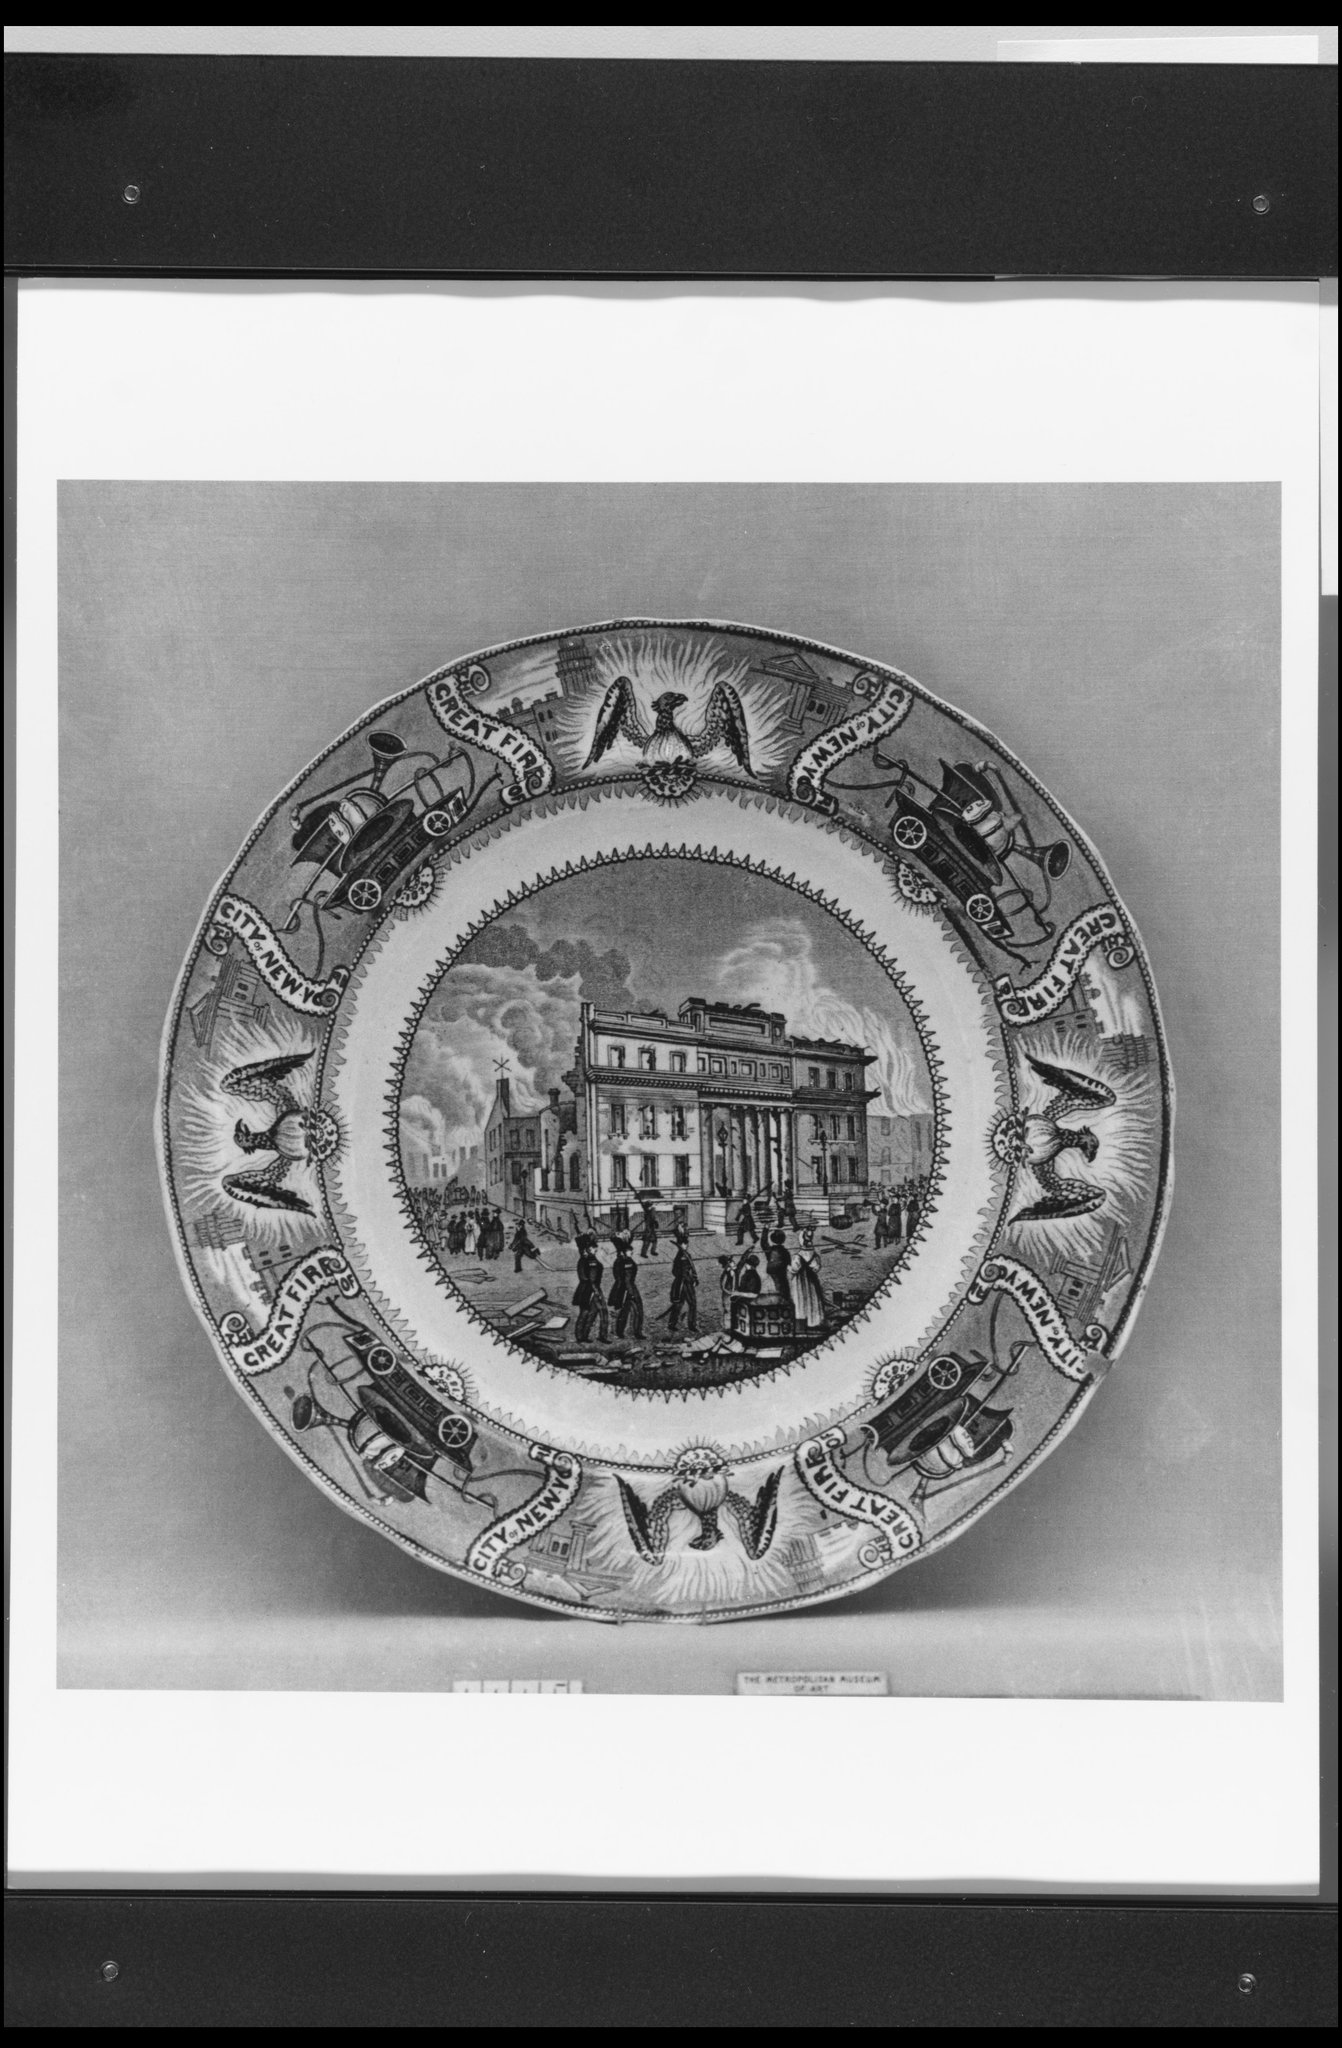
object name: plate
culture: british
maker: thomas dimmock & co.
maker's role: maker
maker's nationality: british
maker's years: 1828-1859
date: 1835-1859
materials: earthenware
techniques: transfer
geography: england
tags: eagles,buildings,fire